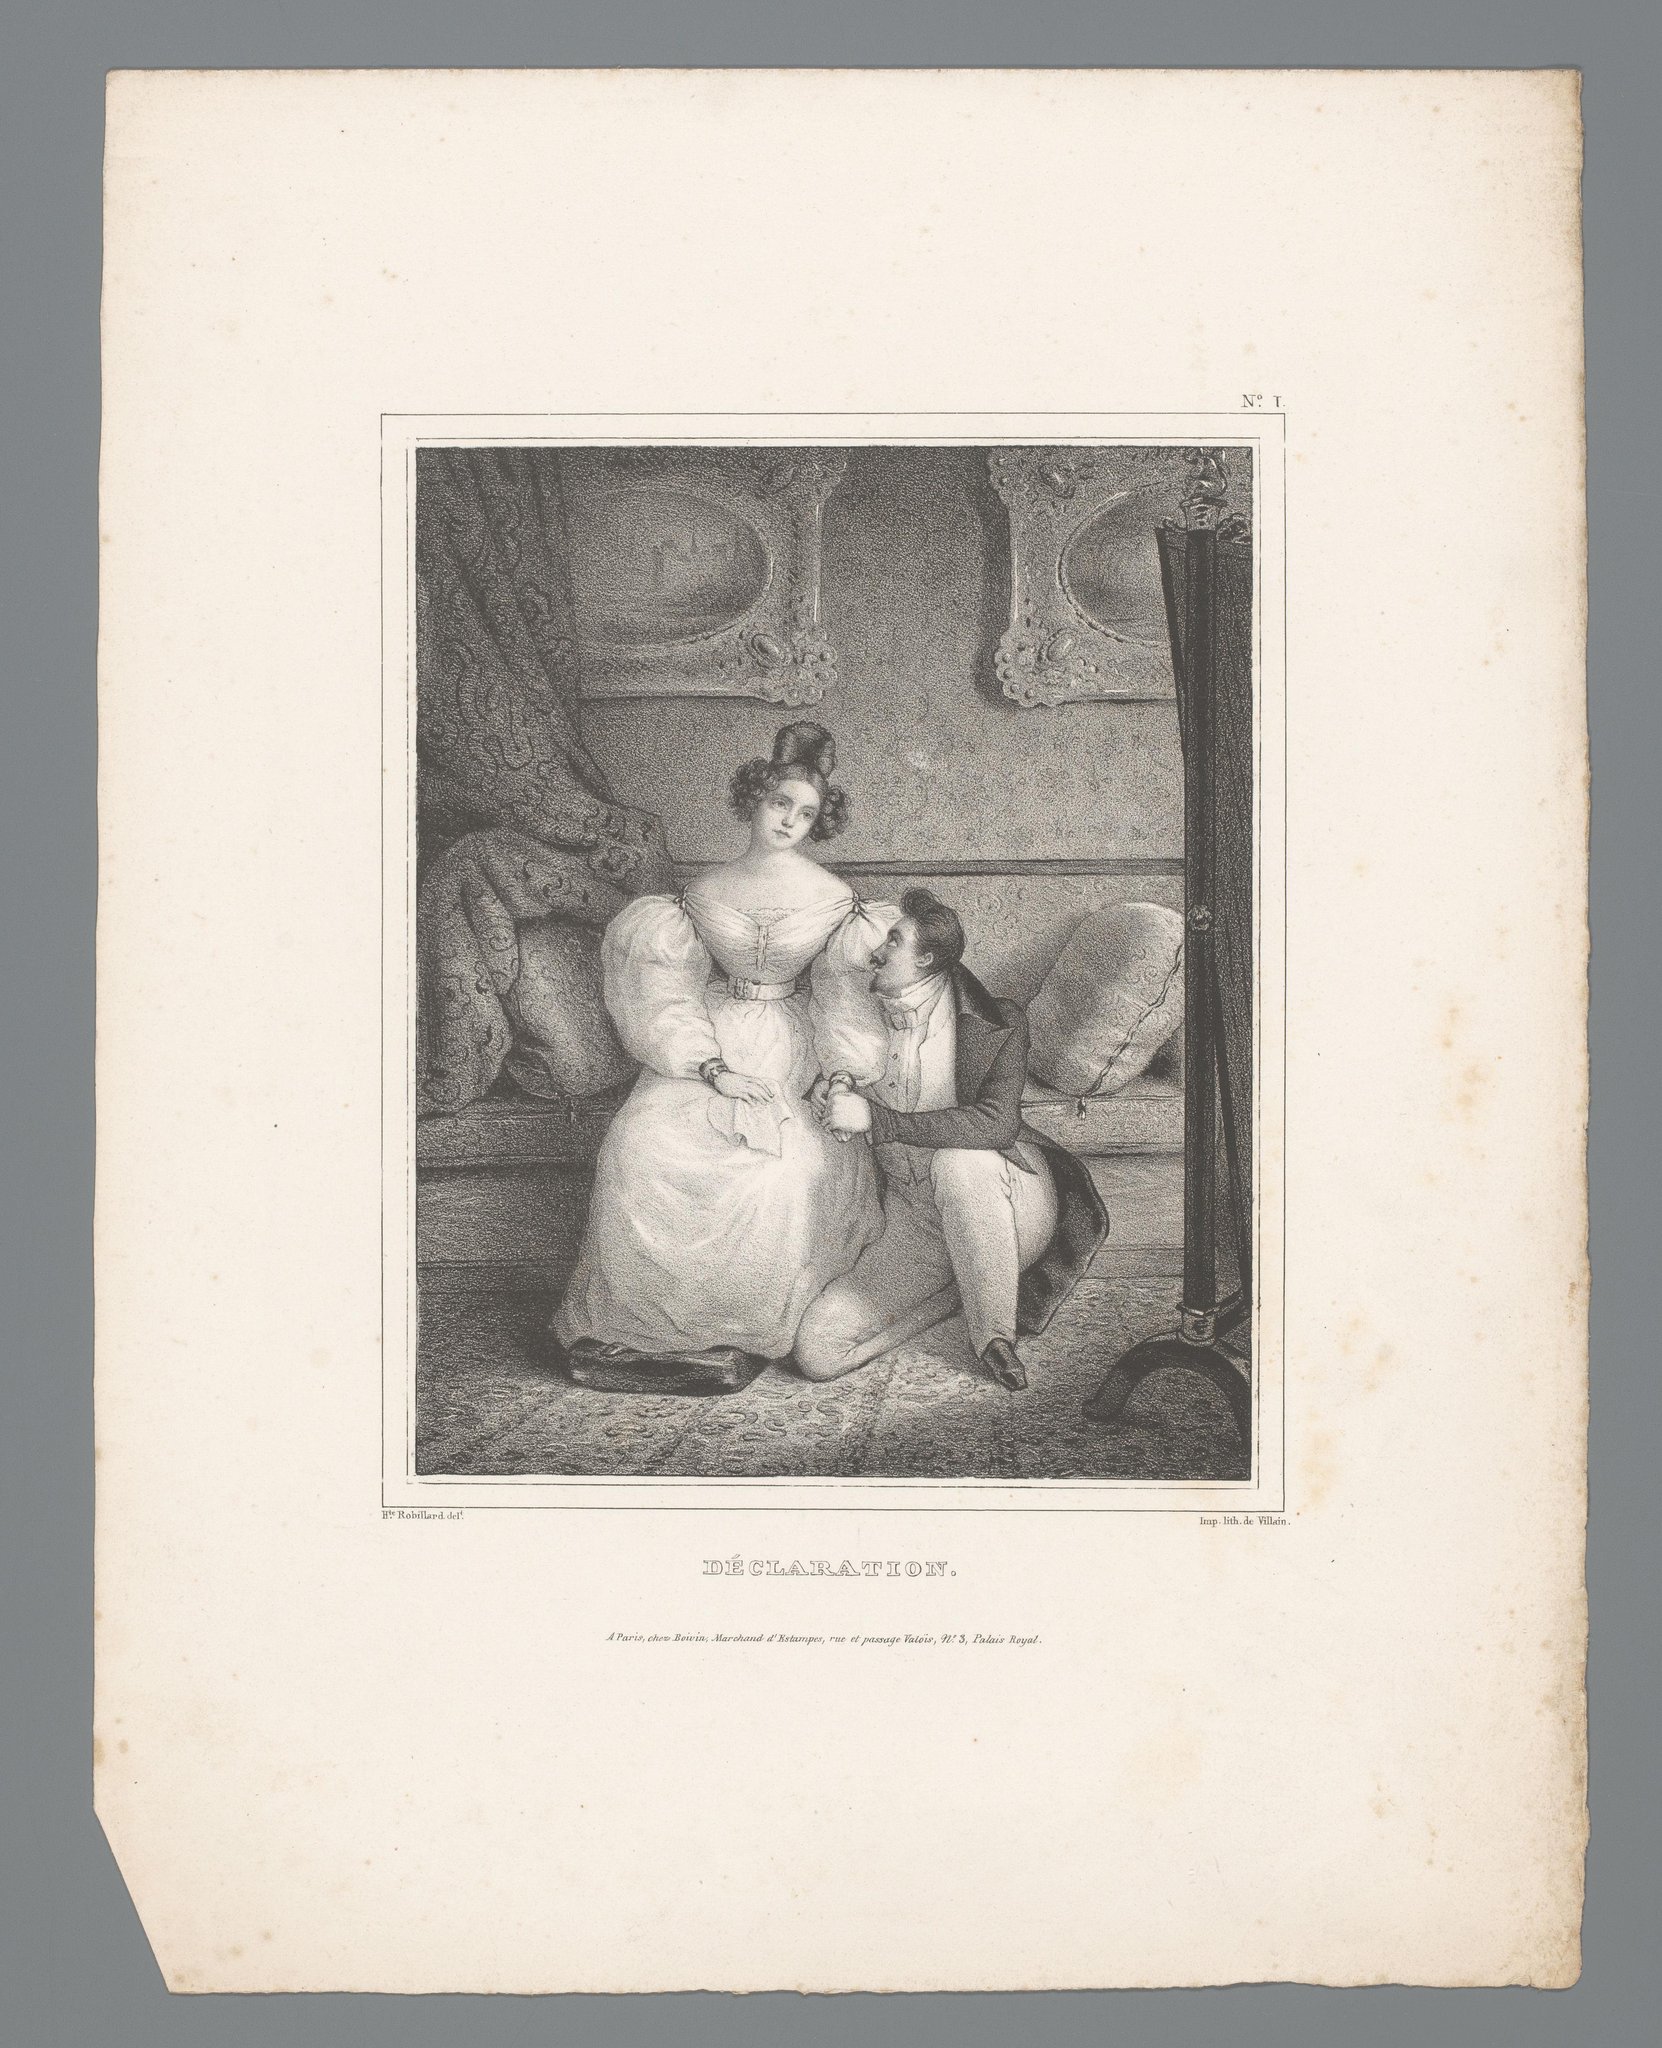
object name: print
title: Man verklaart jonge vrouw de liefde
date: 1832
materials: paper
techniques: lithograph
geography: paris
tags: man kneeling before his beloved (proposing)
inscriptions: collector's mark: Lugt 2228